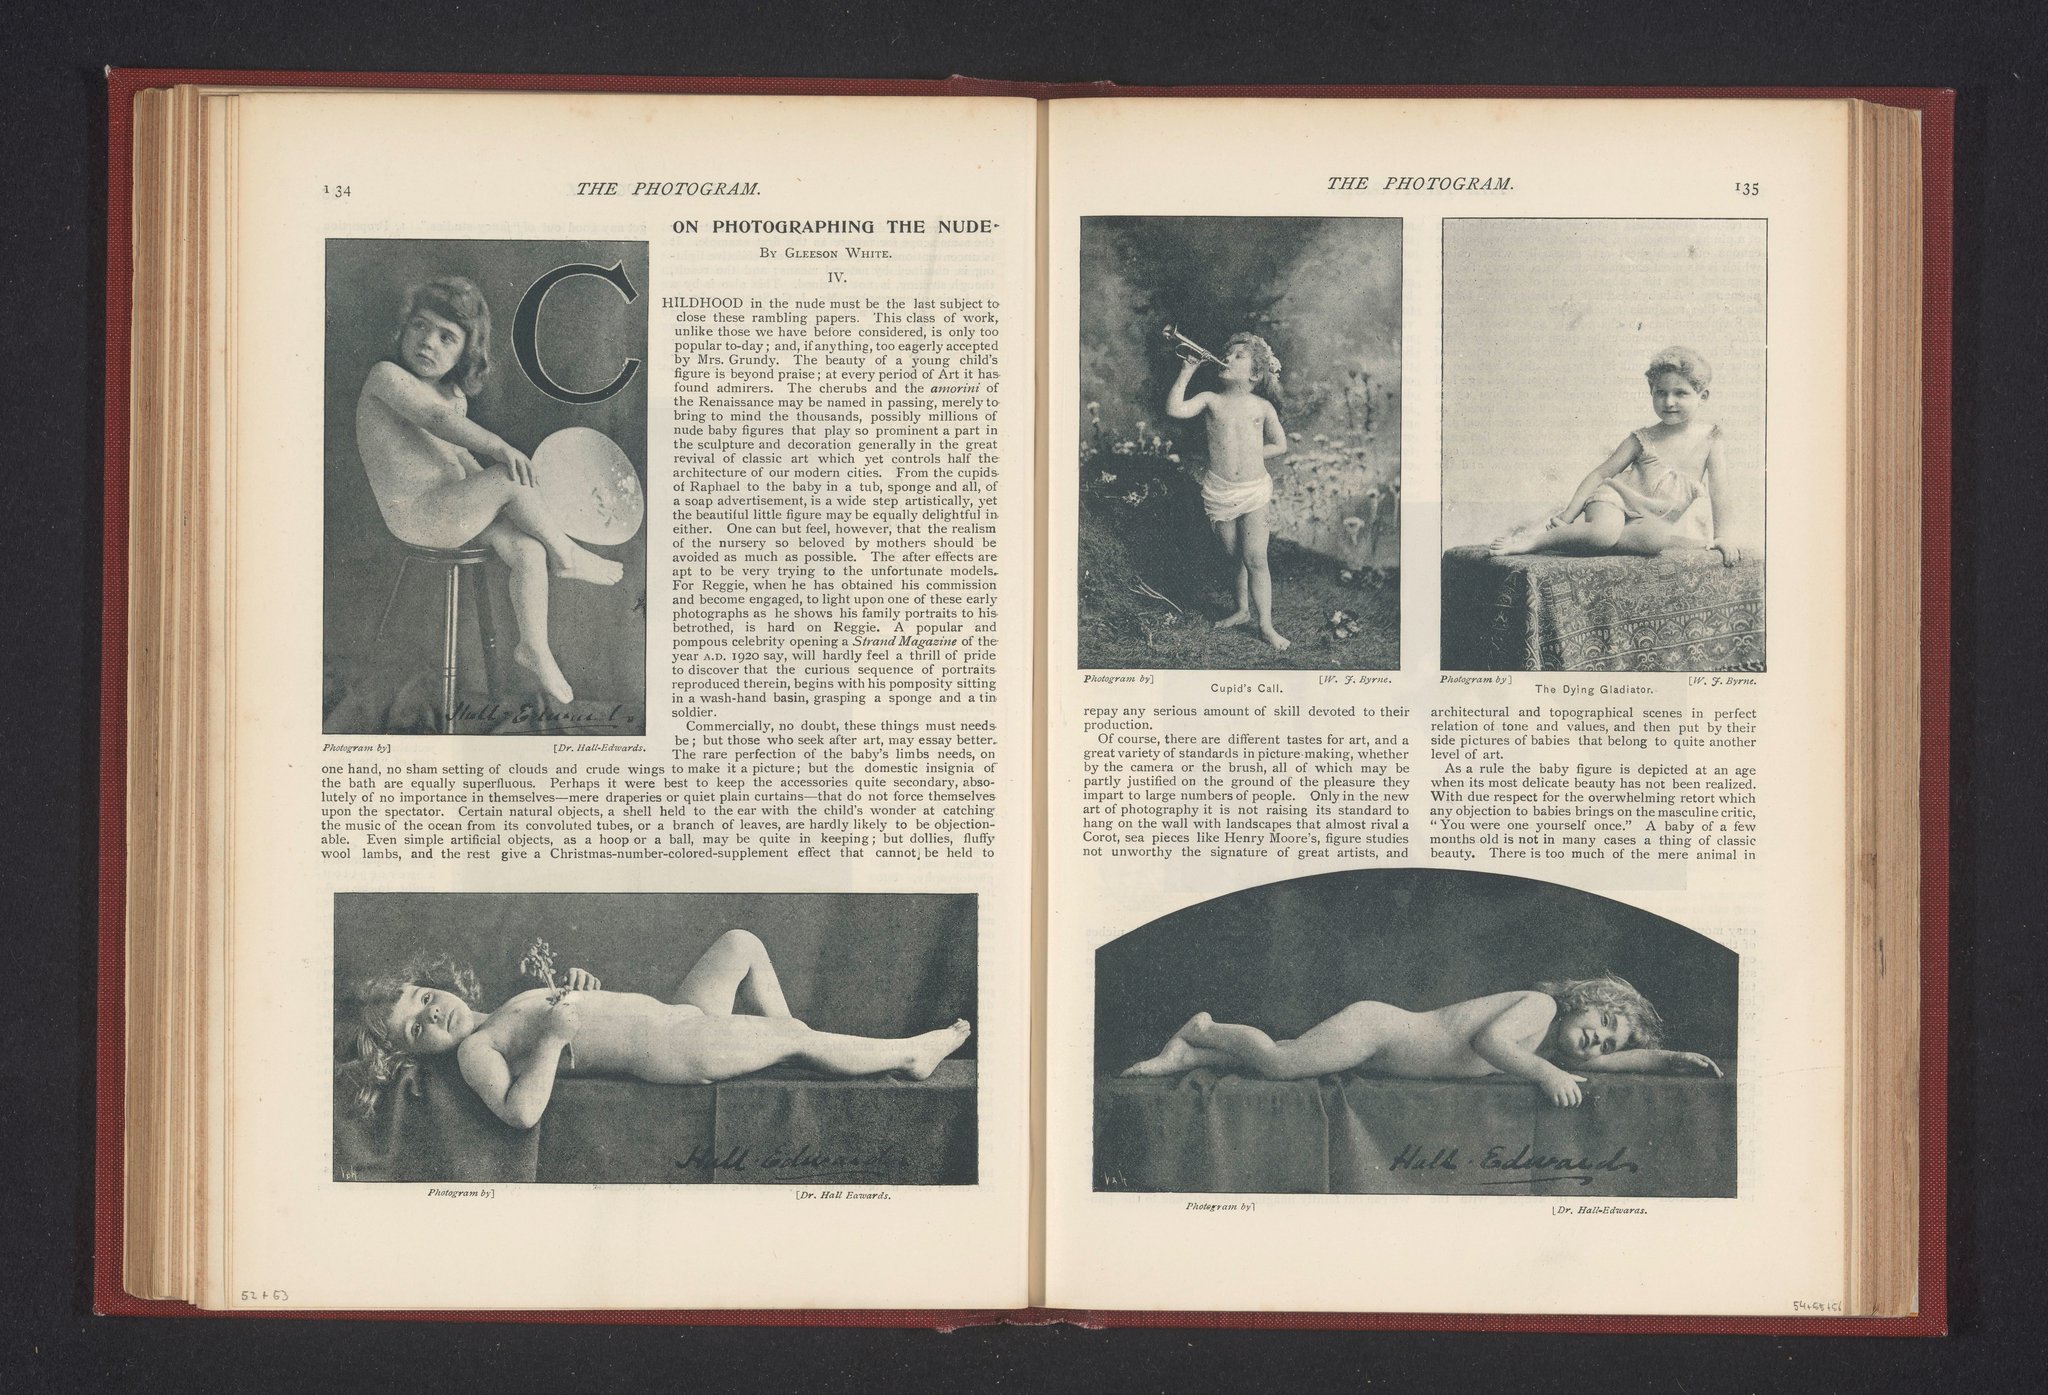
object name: page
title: Portret van een onbekend liggend naakt meisje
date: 1889-1894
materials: paper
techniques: autotype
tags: historical persons - bb - woman, girl (child between toddler and youth), the (nude) human figure; 'corpo humano' (ripa) - aa - female human figure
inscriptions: monogram: ‘V & H’